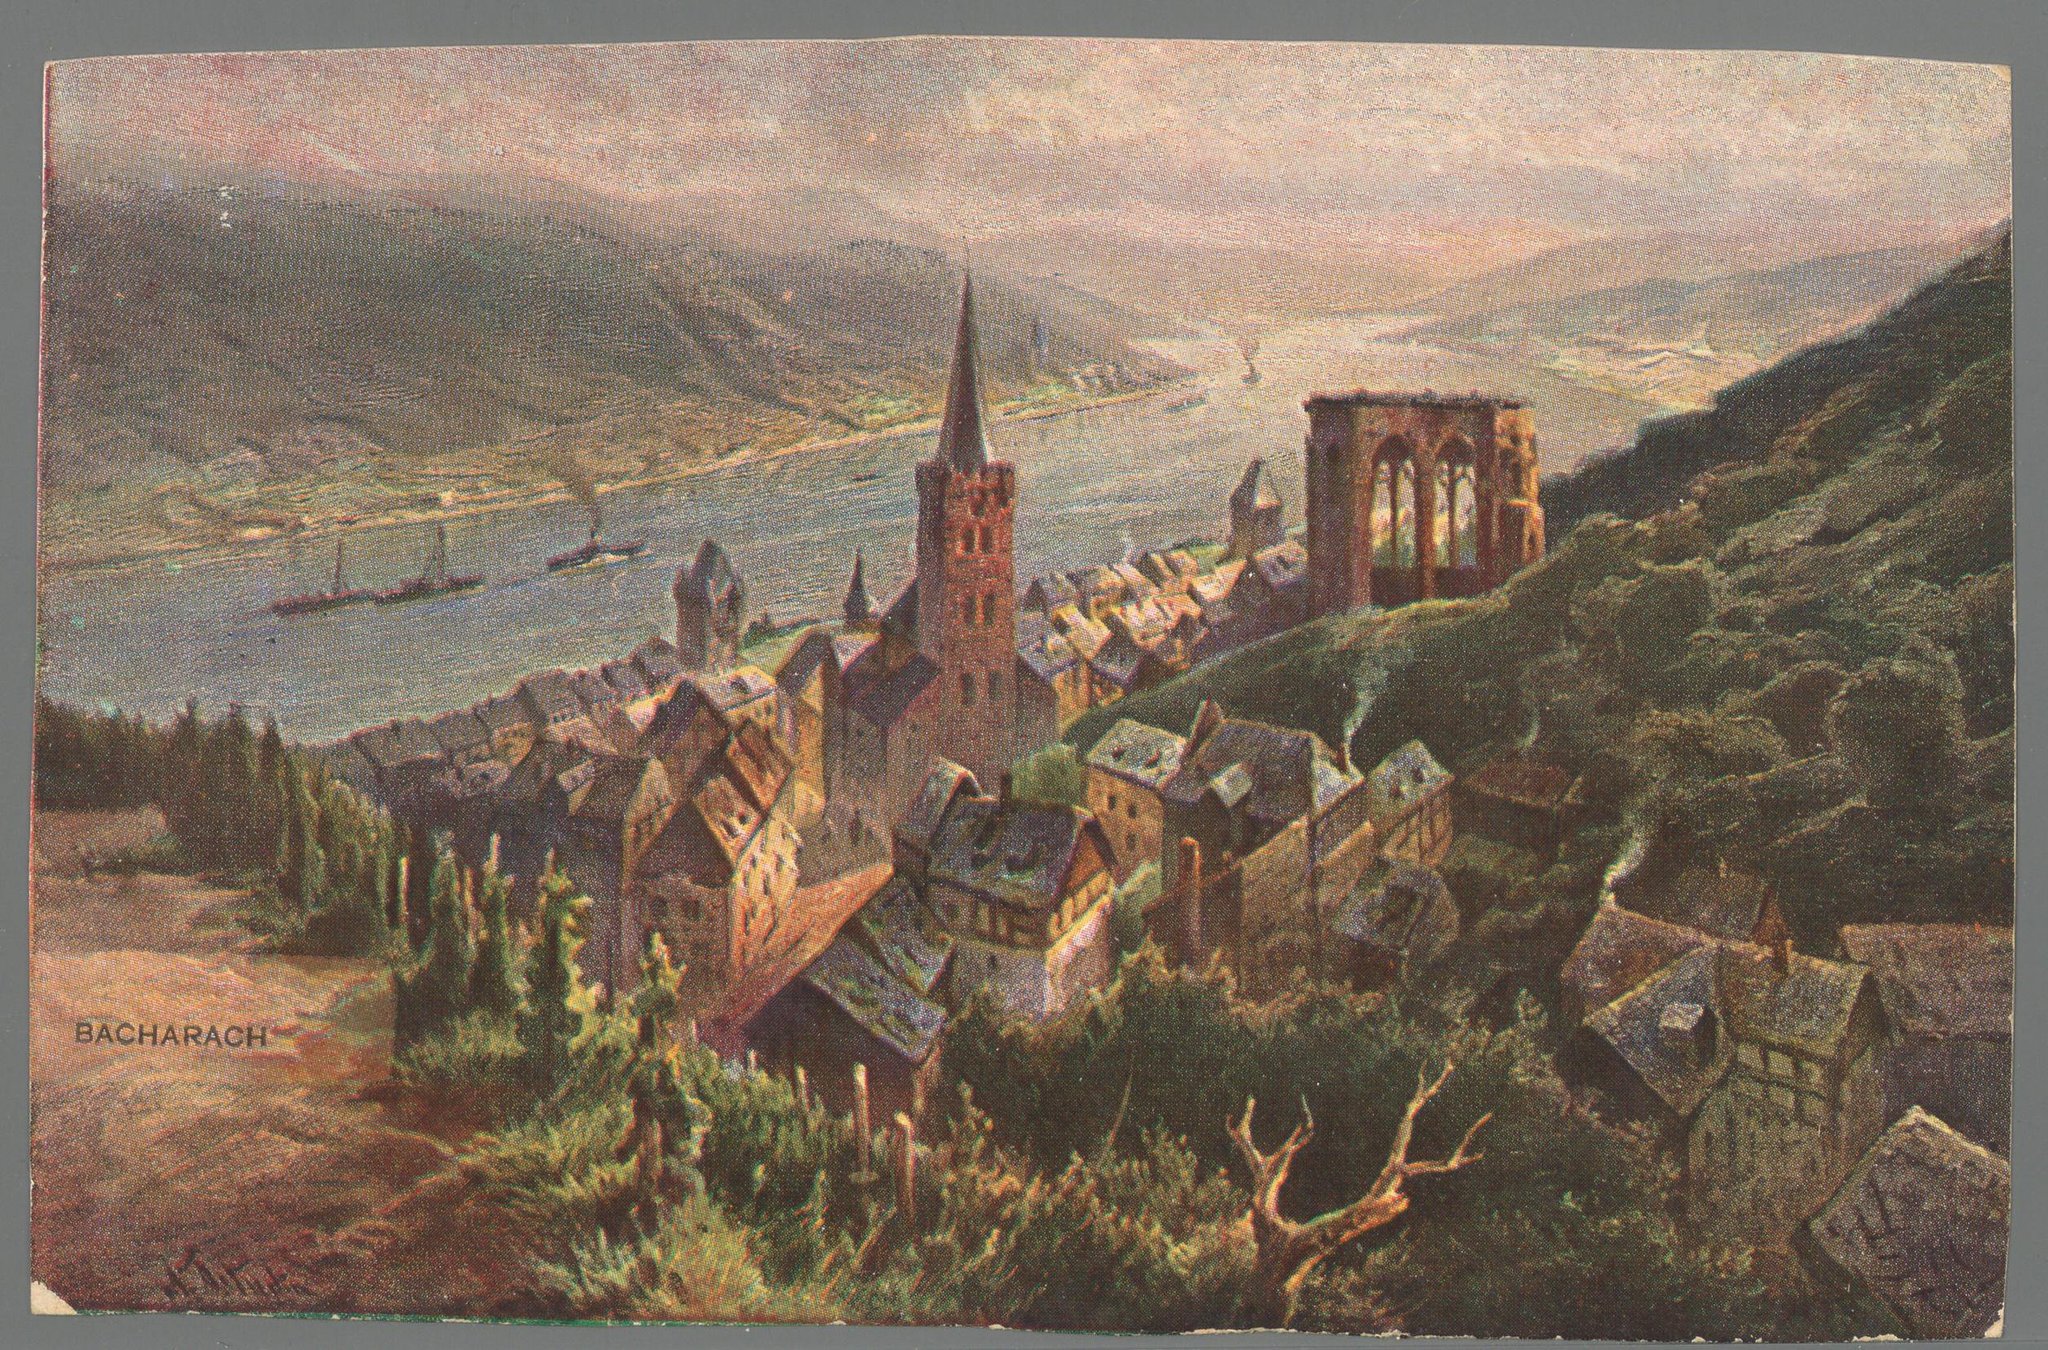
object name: reproduction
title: Astudin-Karten vom Rhein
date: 1905-1930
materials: cardboard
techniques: color autotype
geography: cologne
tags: city-view, and landscape with man-made constructions, river, church (exterior), mountains